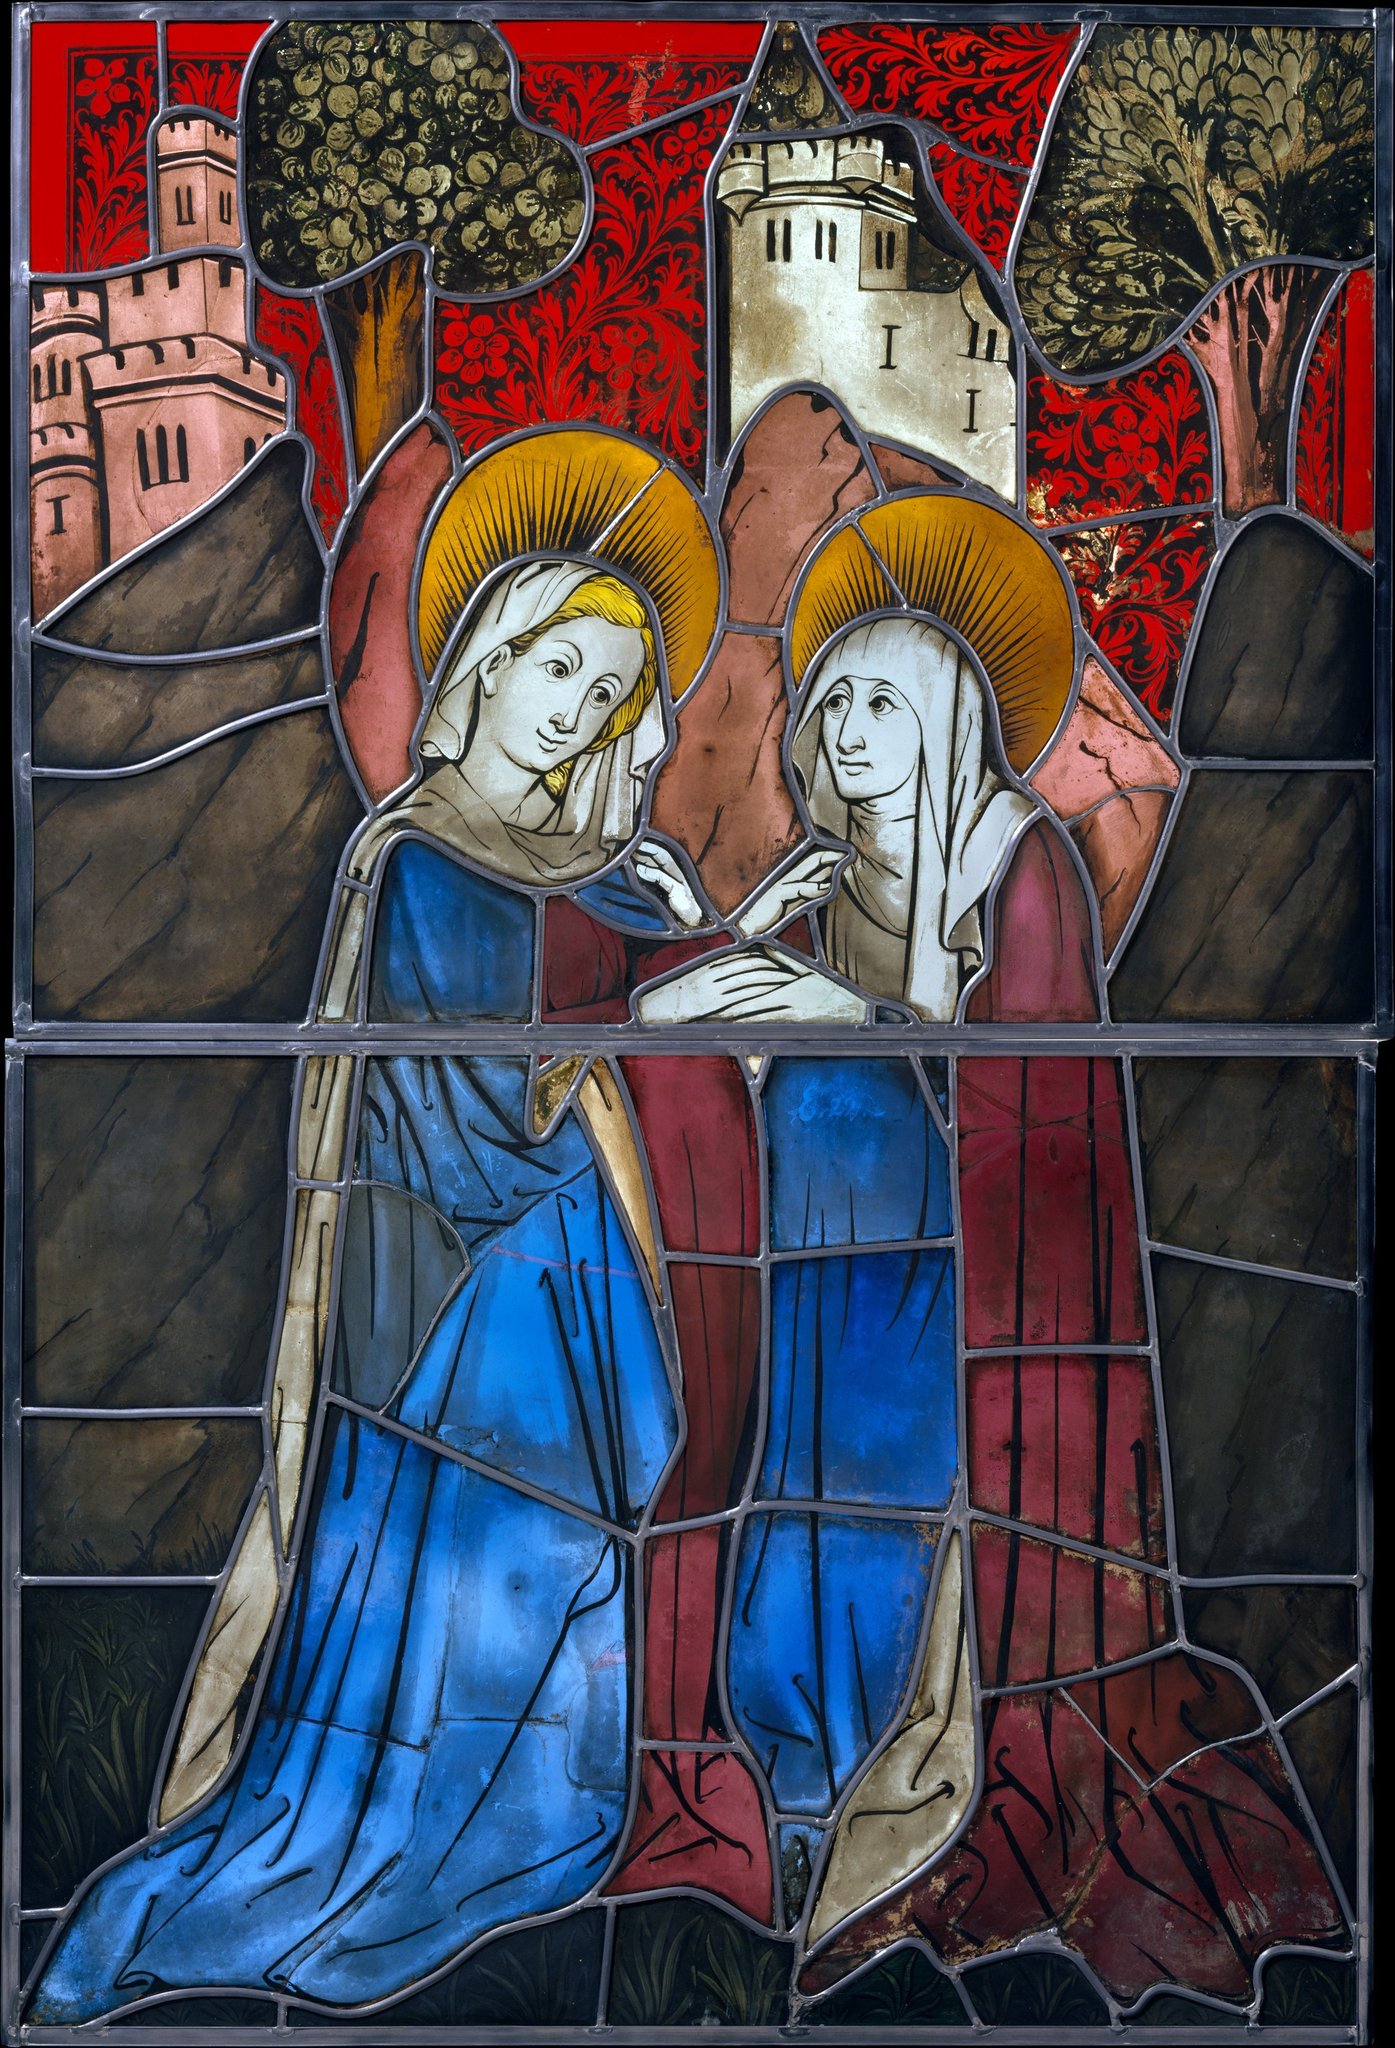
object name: panel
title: Stained Glass Panel with the Visitation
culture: german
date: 1444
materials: enamel, glass, metal, paint, pigment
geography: germany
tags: virgin mary,visitation